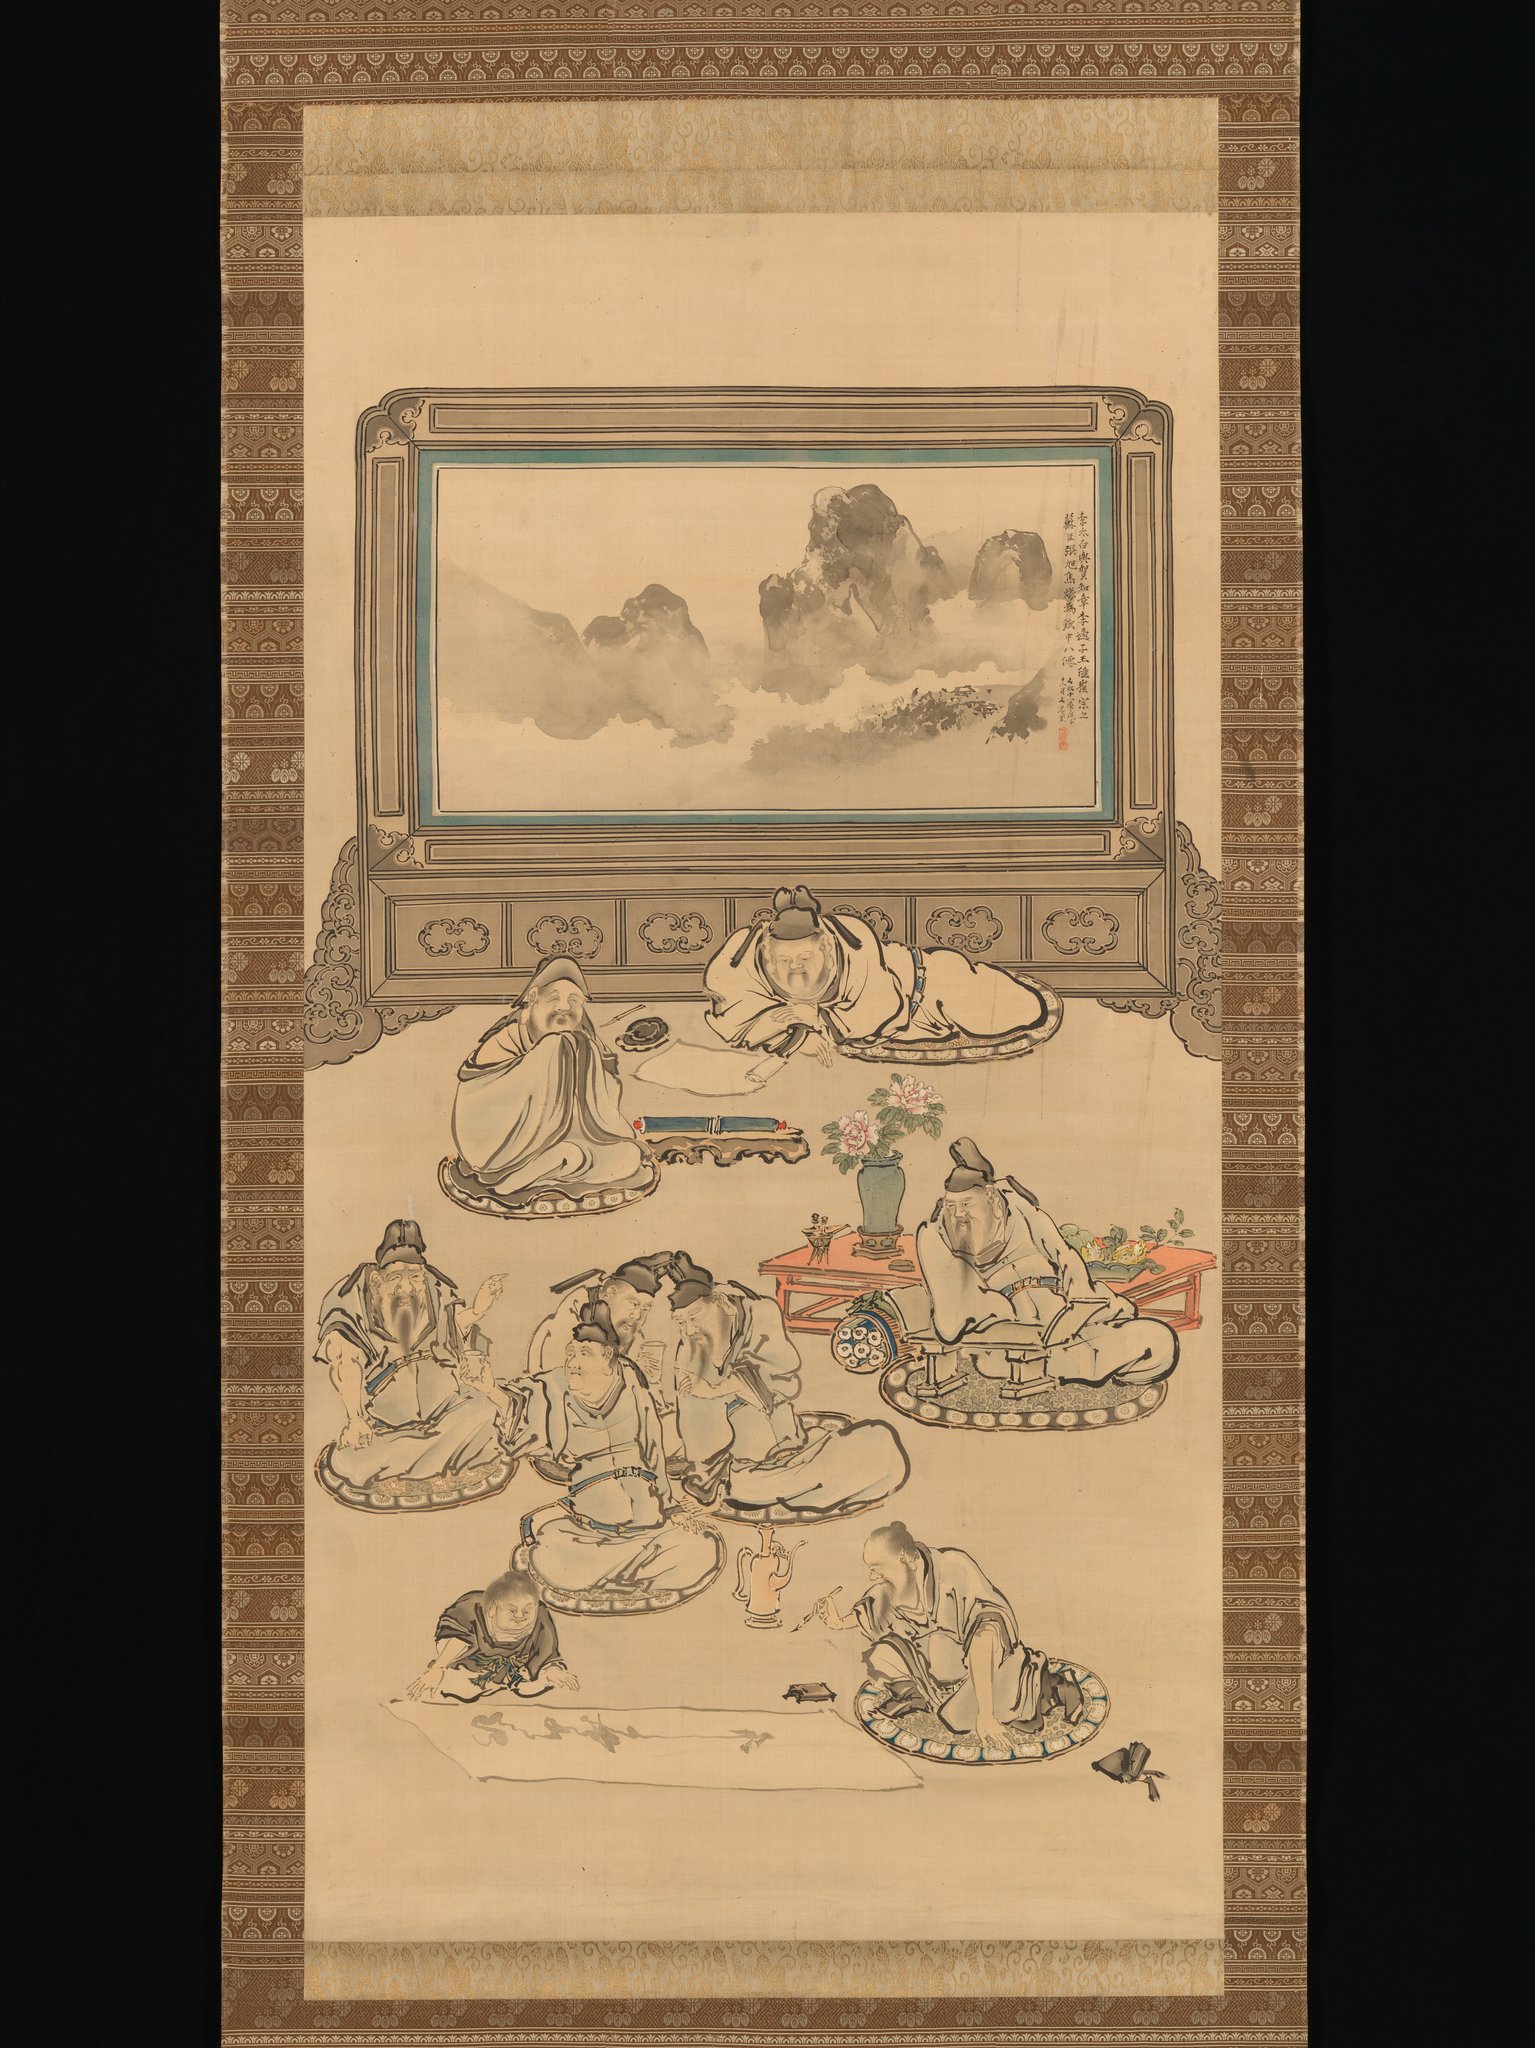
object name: hanging scroll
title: The Eight Immortals of the Wine Cup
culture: japanese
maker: tani bunchō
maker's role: artist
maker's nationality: japanese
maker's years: 1763-1840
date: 1828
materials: ink, silk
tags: men